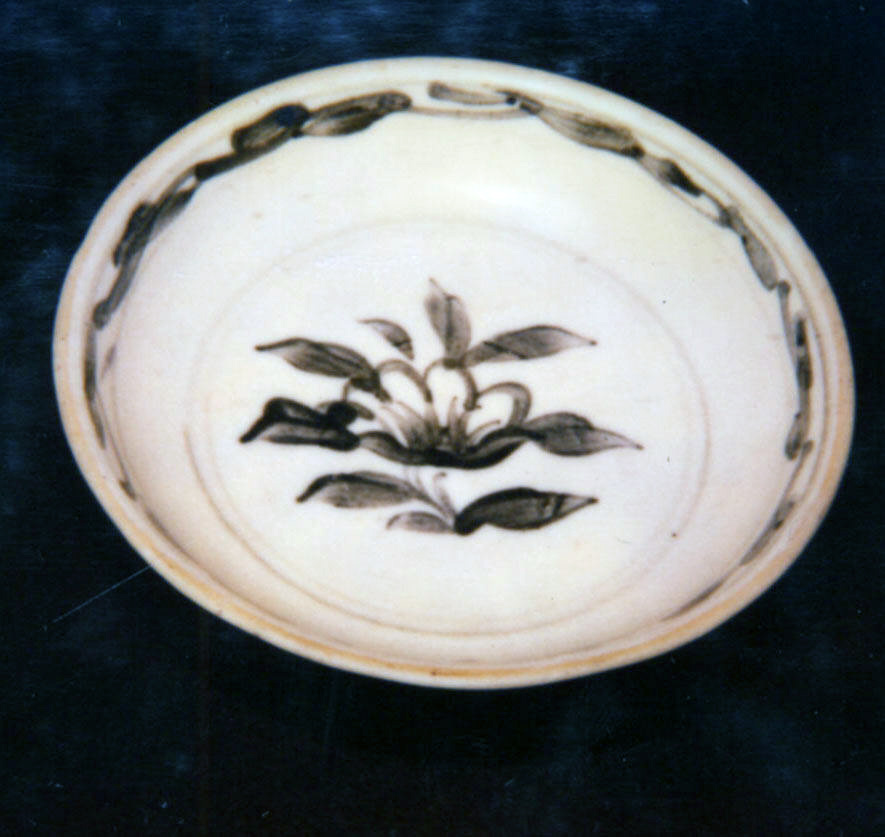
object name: dish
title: Small Dish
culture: vietnamese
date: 1401-1600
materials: cobalt, stoneware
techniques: underglaze